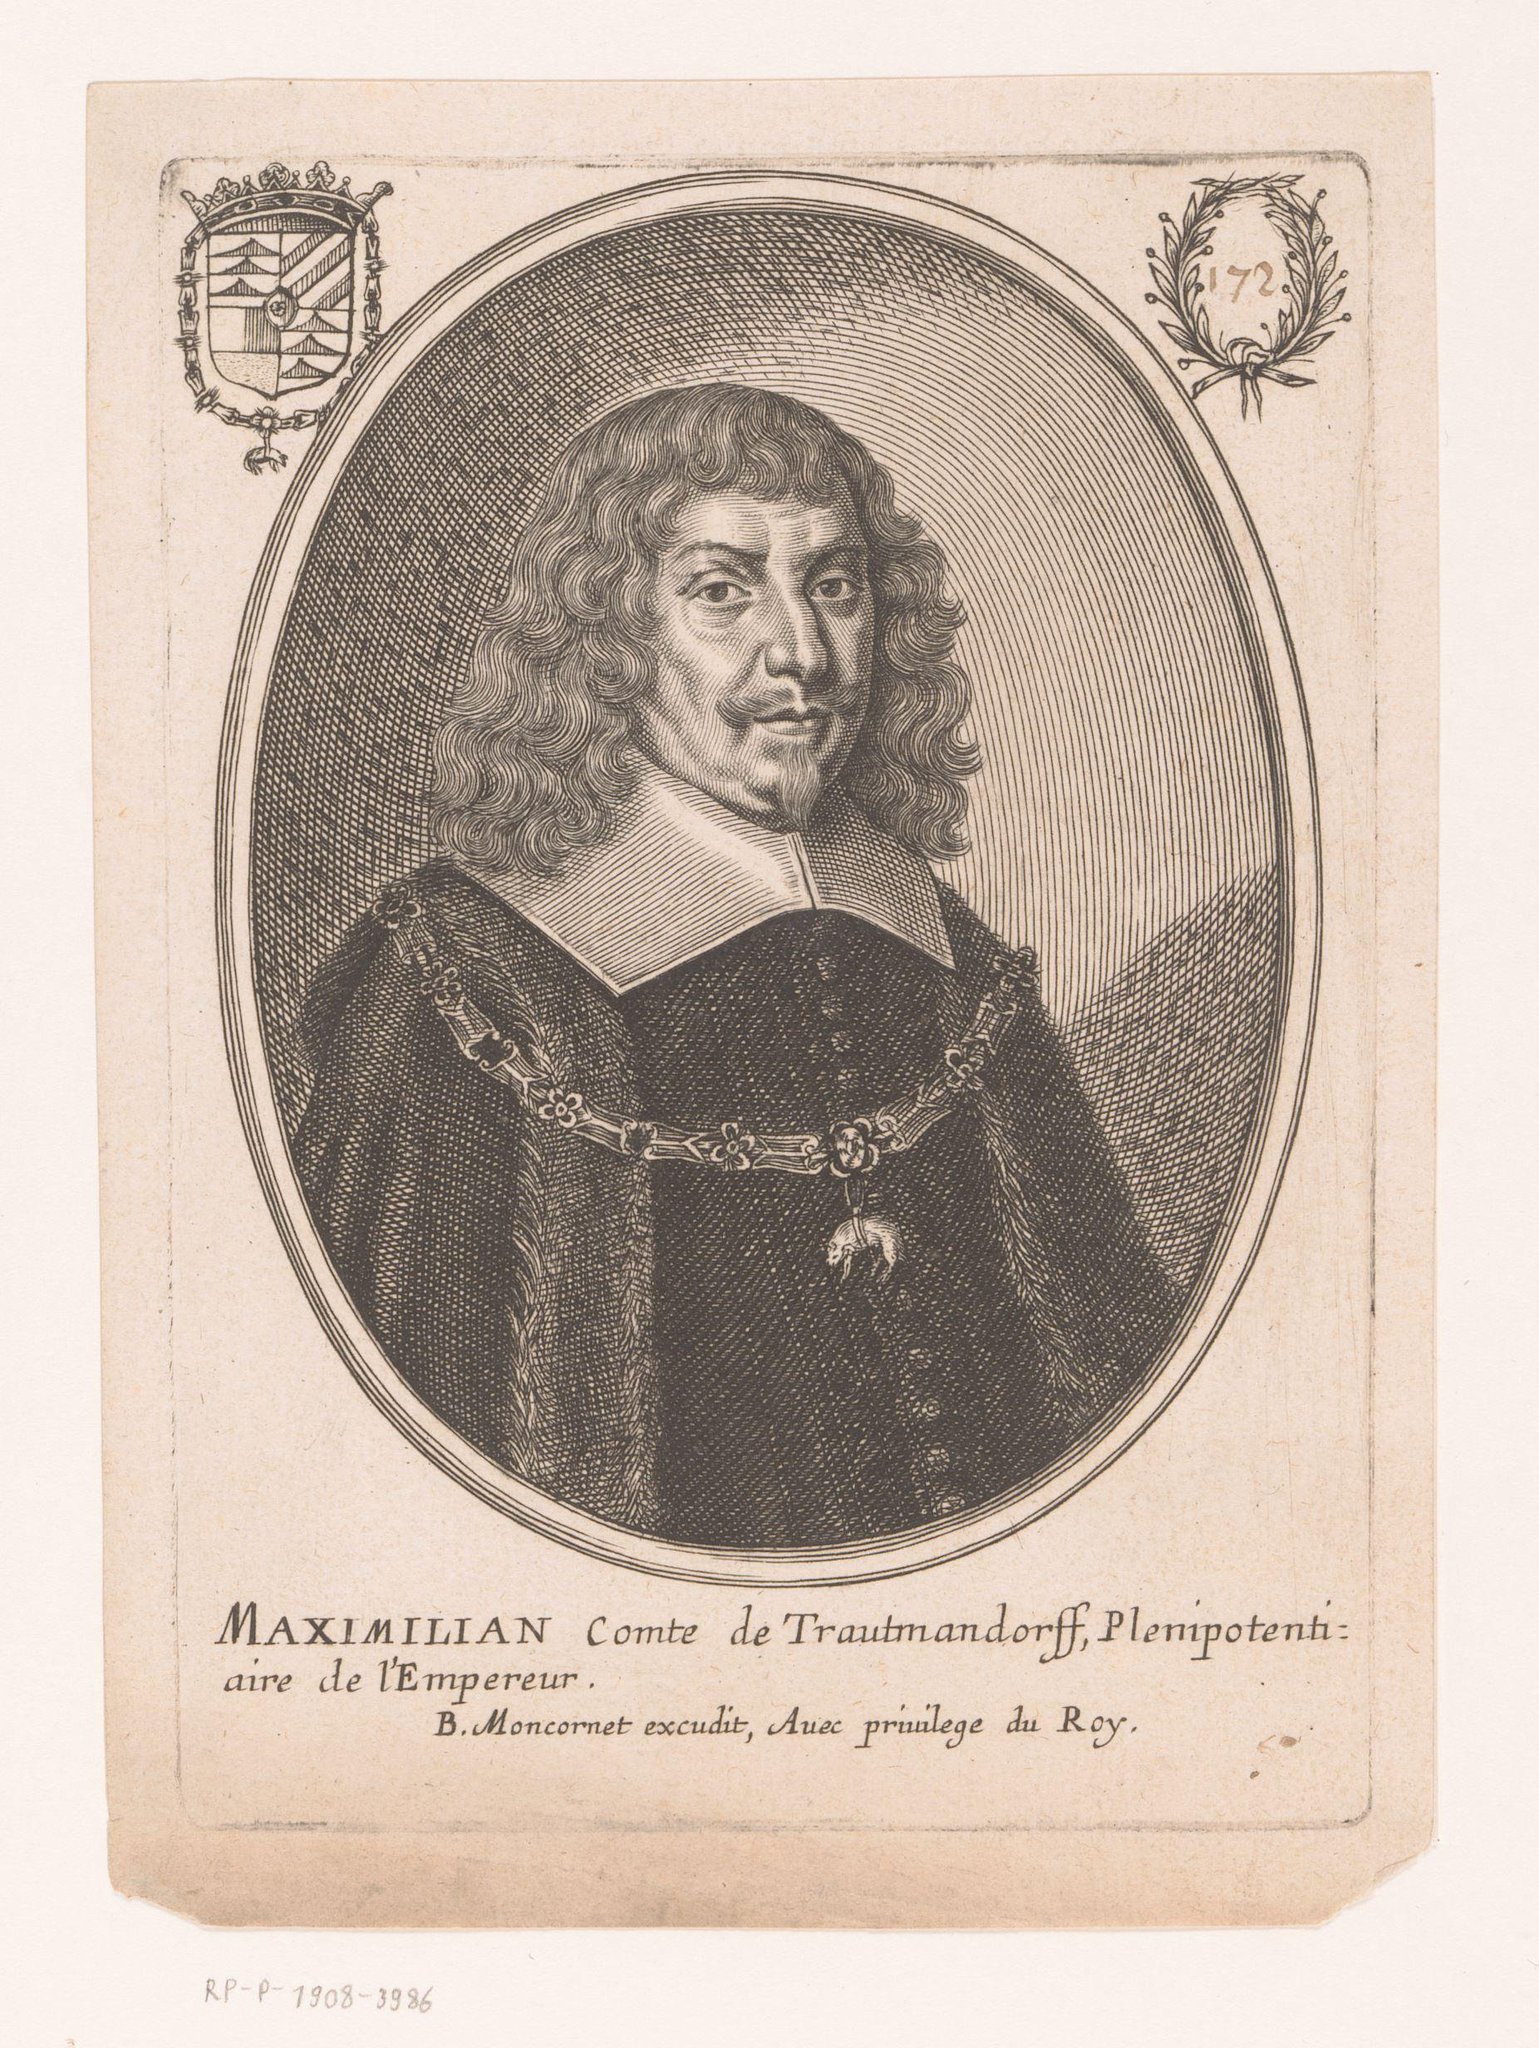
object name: print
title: Portret van Maximilian von und zu Trauttmansdorff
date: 1634-1668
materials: paper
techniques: engraving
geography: paris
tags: vienna, historical persons, politician, e.g. party leader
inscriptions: collector's mark: Lugt 2228, number: ‘172’